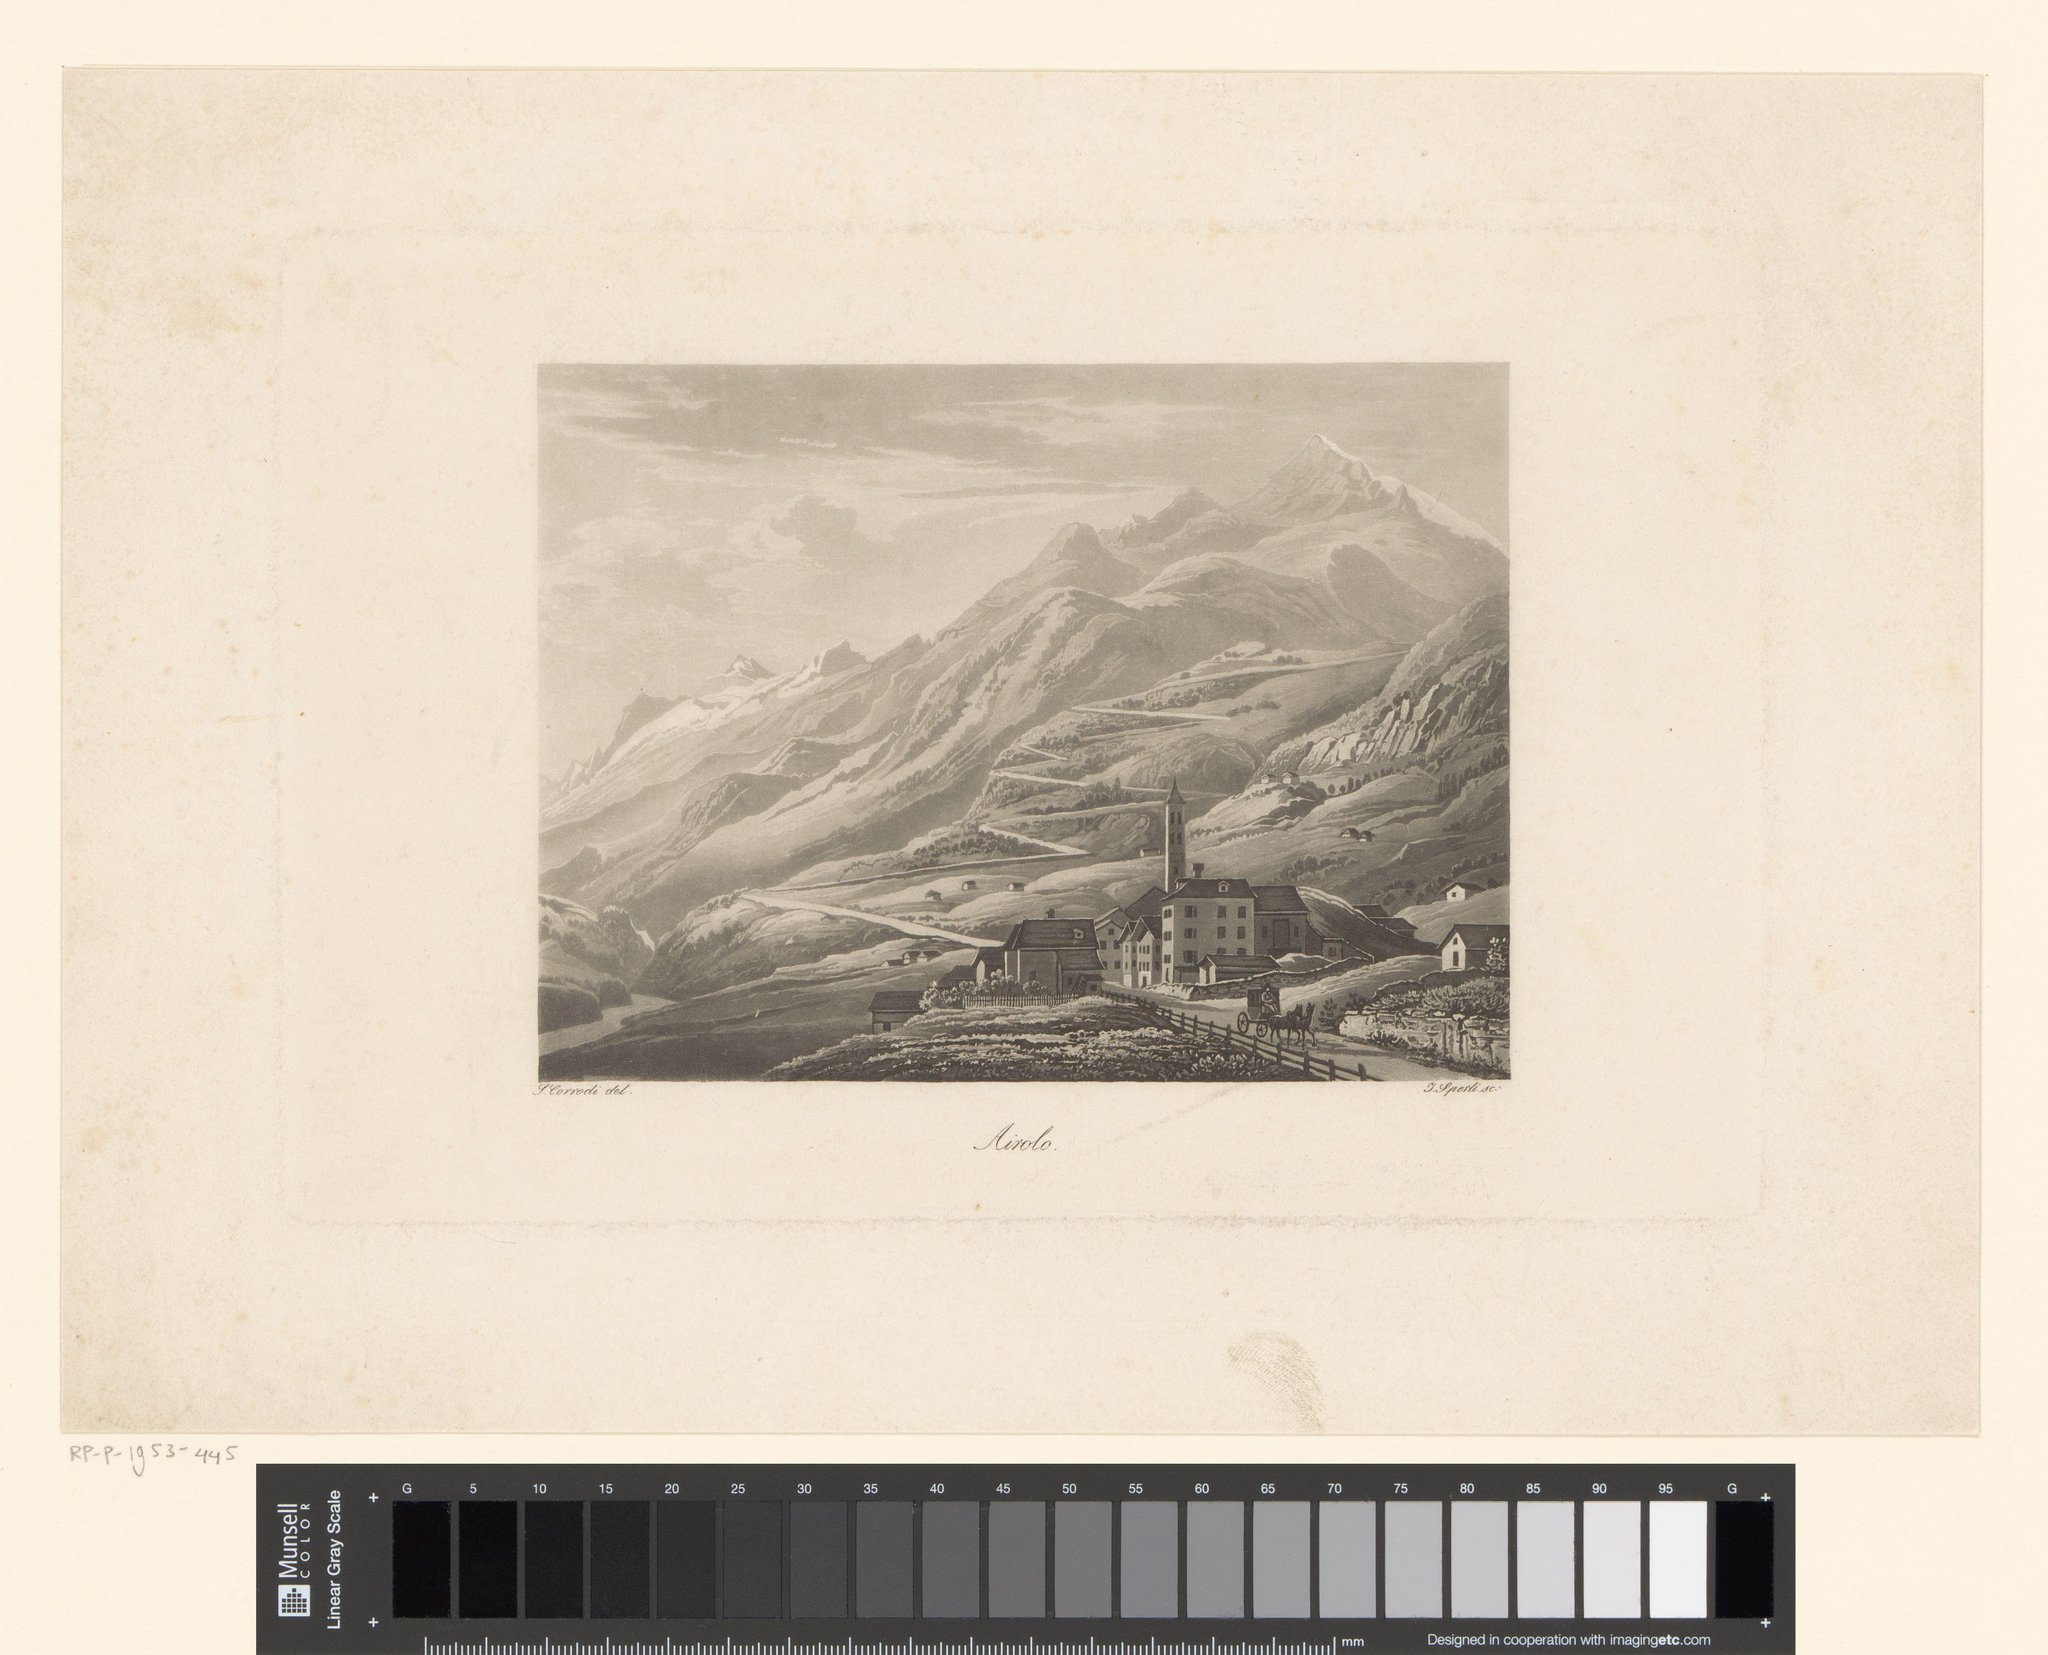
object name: print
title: Airolo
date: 1780-1843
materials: paper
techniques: aquatint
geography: switzerland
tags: river, landscapes (+ landscape with figures, staffage), mountains, switzerland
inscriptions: collector's mark: Lugt 2228, collector's mark: Lugt 2760